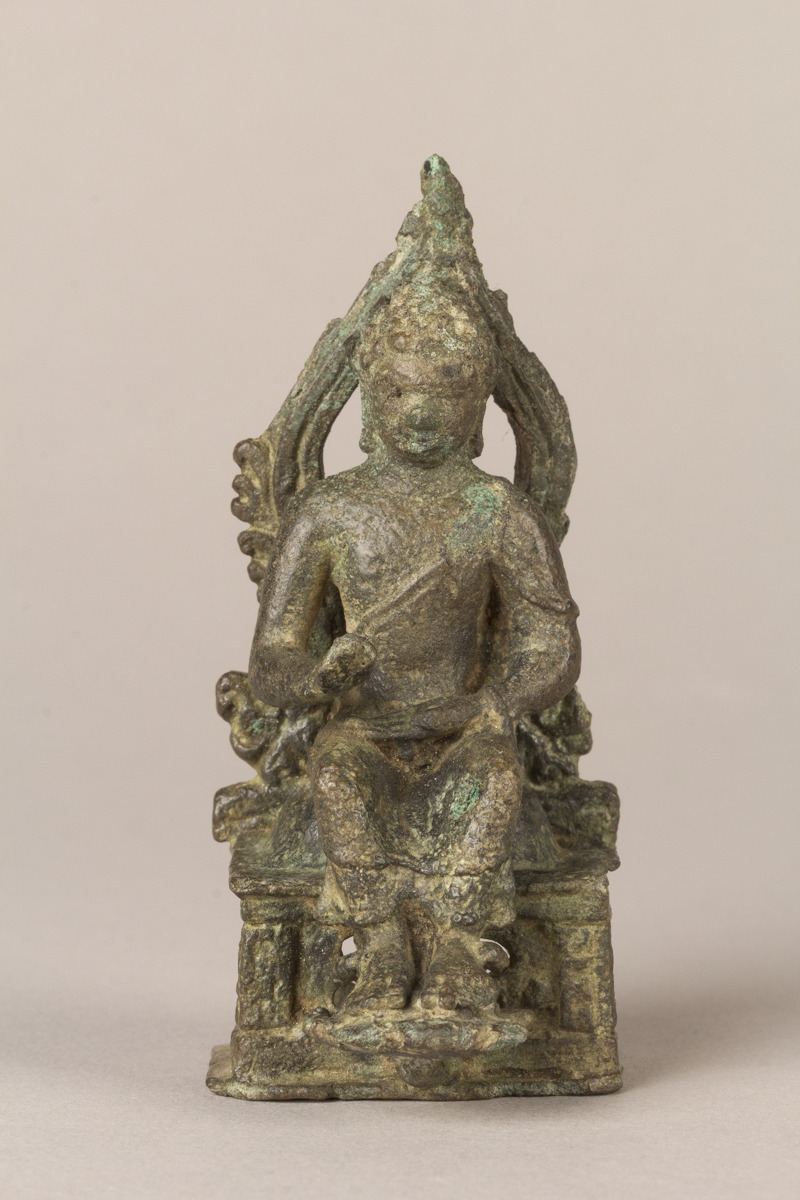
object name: fragment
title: Fragment of a Seated Buddha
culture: indonesian, kalimantan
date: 701-800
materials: bronze